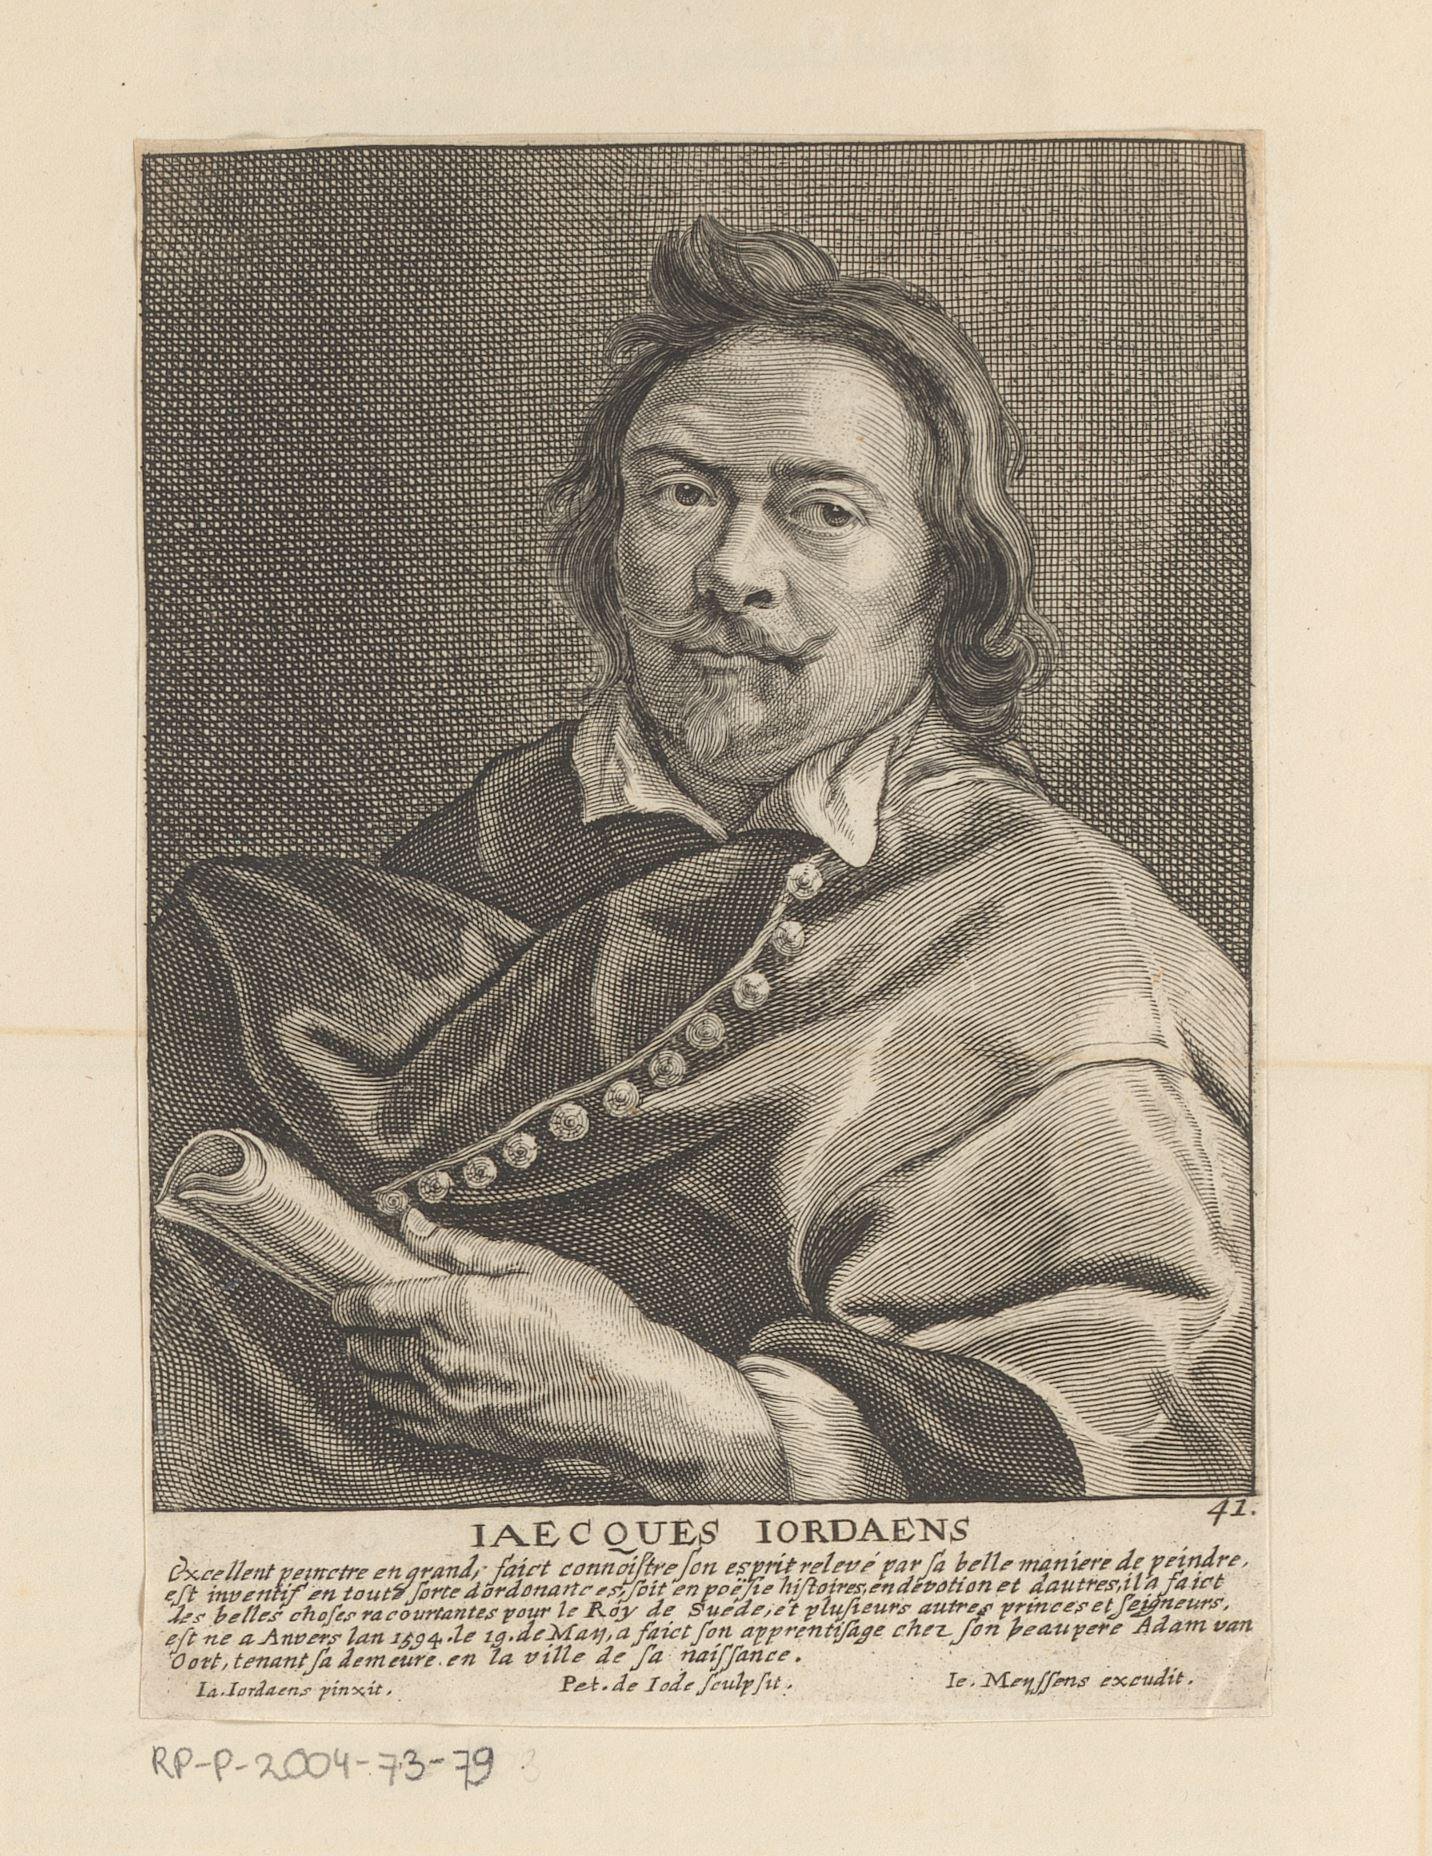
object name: album leaf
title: Portret van Jacques Jordaens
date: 1649-1662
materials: paper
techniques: engraving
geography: antwerp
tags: antwerp, painter, print maker, draughtsman, designer, jacques jordaens, historical persons, portrait, self-portrait of painter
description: Prent mogelijk uit: Meyssens, Joannes. Image de divers hommes desprit sublime qui par leur art et science deburovent vivre eternellement et des quels la louange et renommée faict estonner le monde. 2 dln. Antwerpen: Joannes Meyssens, 1649, dl. 1, p. 30. Andere staat van prent gebruikt in: Bie, Cornelis De. Het gulden Cabinet vande edel vry schilder const, inhoudende den lof vande vermarste schilders, architecte, beldthowers ende plaetsnyders van dese eeuw. Antwerpen: Joannes Meyssens, 1662 [1661 foutief op titelpagina], p. 239. De samensteller heeft deze prent in het album geplakt als illustratie bij: Pilkington, Matthew en Johann Heinrich Füssli. A dictionary of painters, from the revival of the art to the present period. 4 dln. Londen: John Crowder, 1805, dl. 2, p. 264.